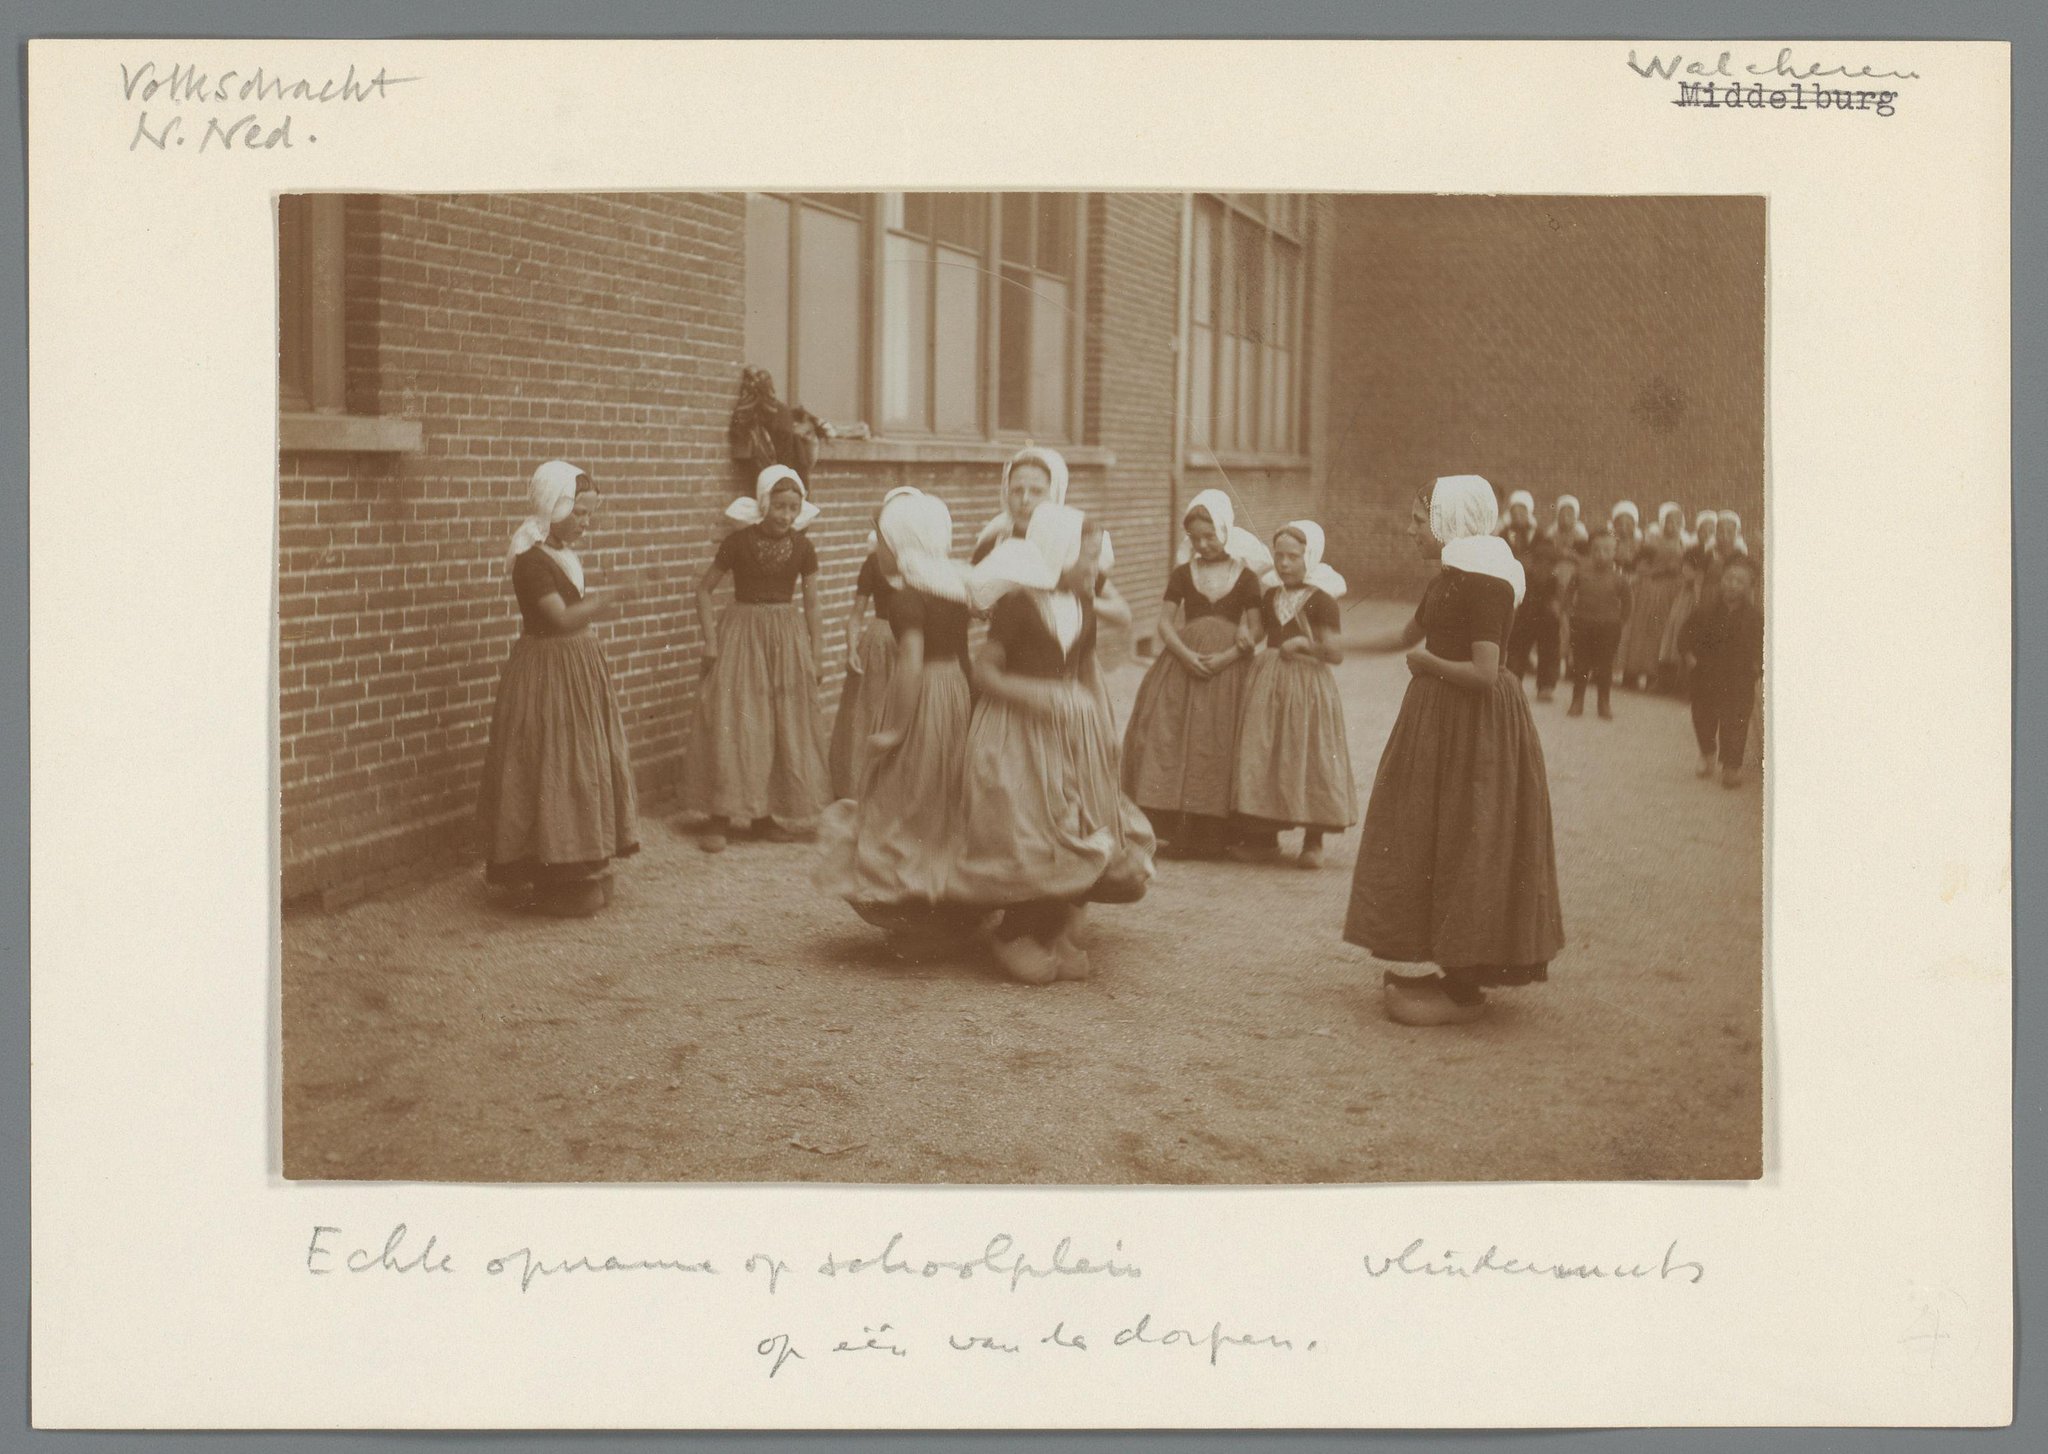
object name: photograph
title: Middelburg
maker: Anonymous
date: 1880-1920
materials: paper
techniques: collodion silver print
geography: walcheren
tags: historical persons - bb - woman, folk costume, regional costume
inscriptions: inscription: ‘Echte opname op schoolplein vlindermuts/ op één van de dorpen.’, number: ‘- 5260 44’, inscription: ‘Volksdracht/ N.Ned./ Walcheren’, number: ‘352.365’